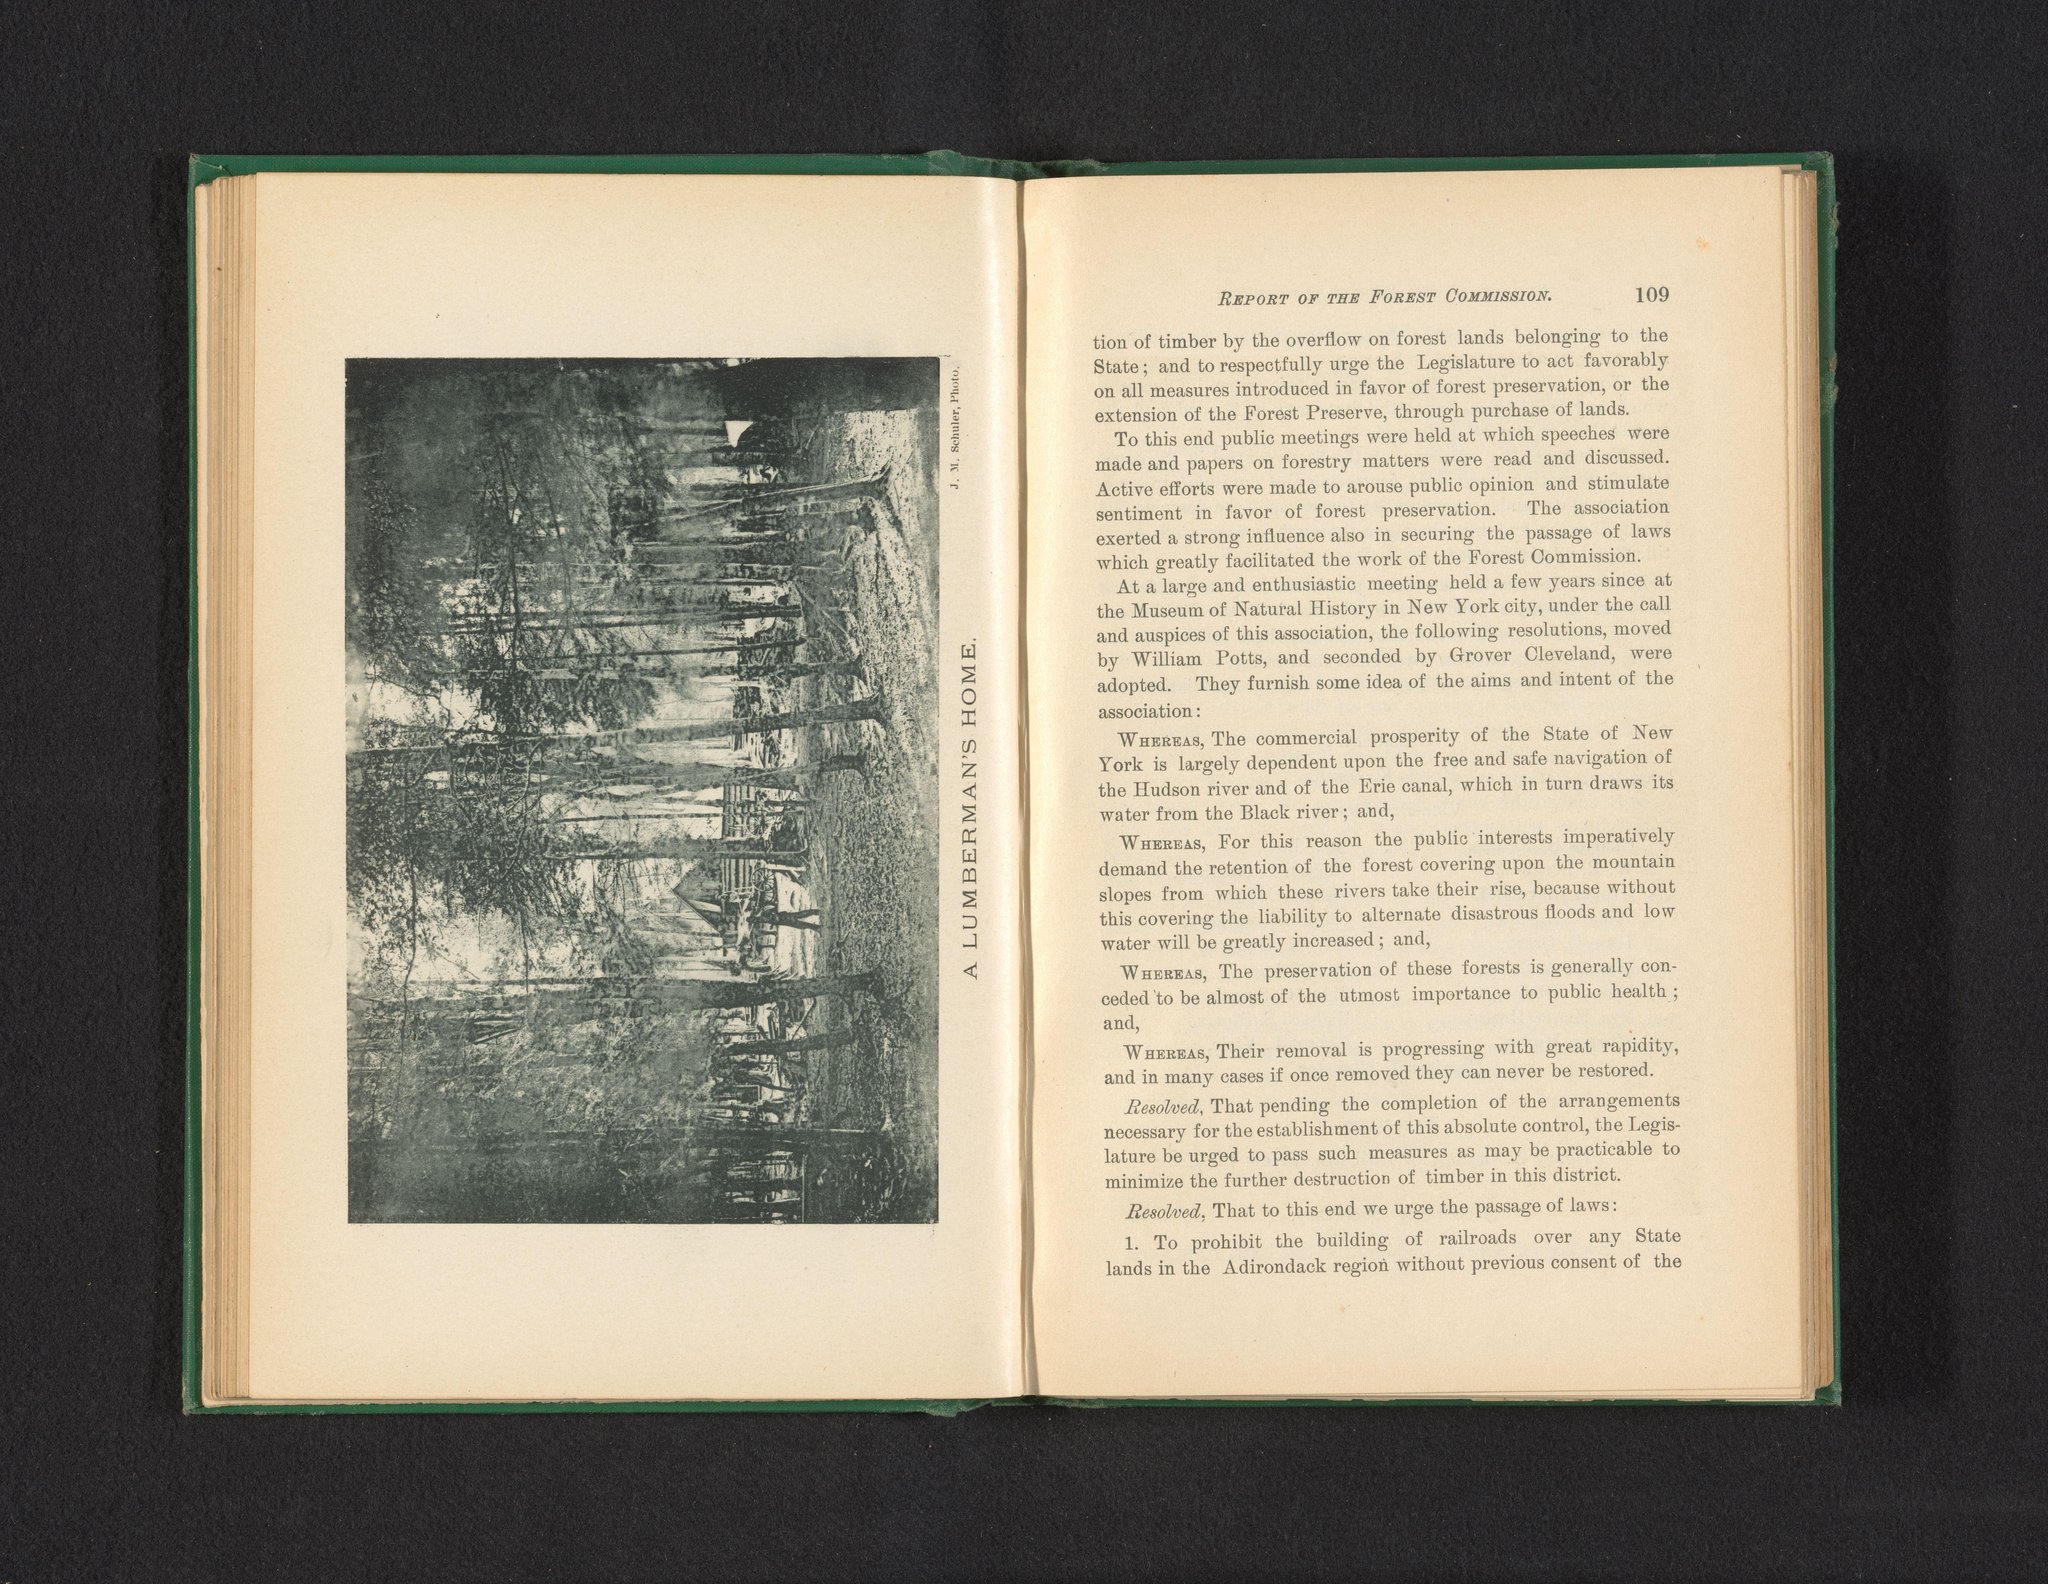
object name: page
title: A lumberman's home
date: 1894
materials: paper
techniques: photograph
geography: new york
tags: façade (of house or building), hut, cabin, lodge